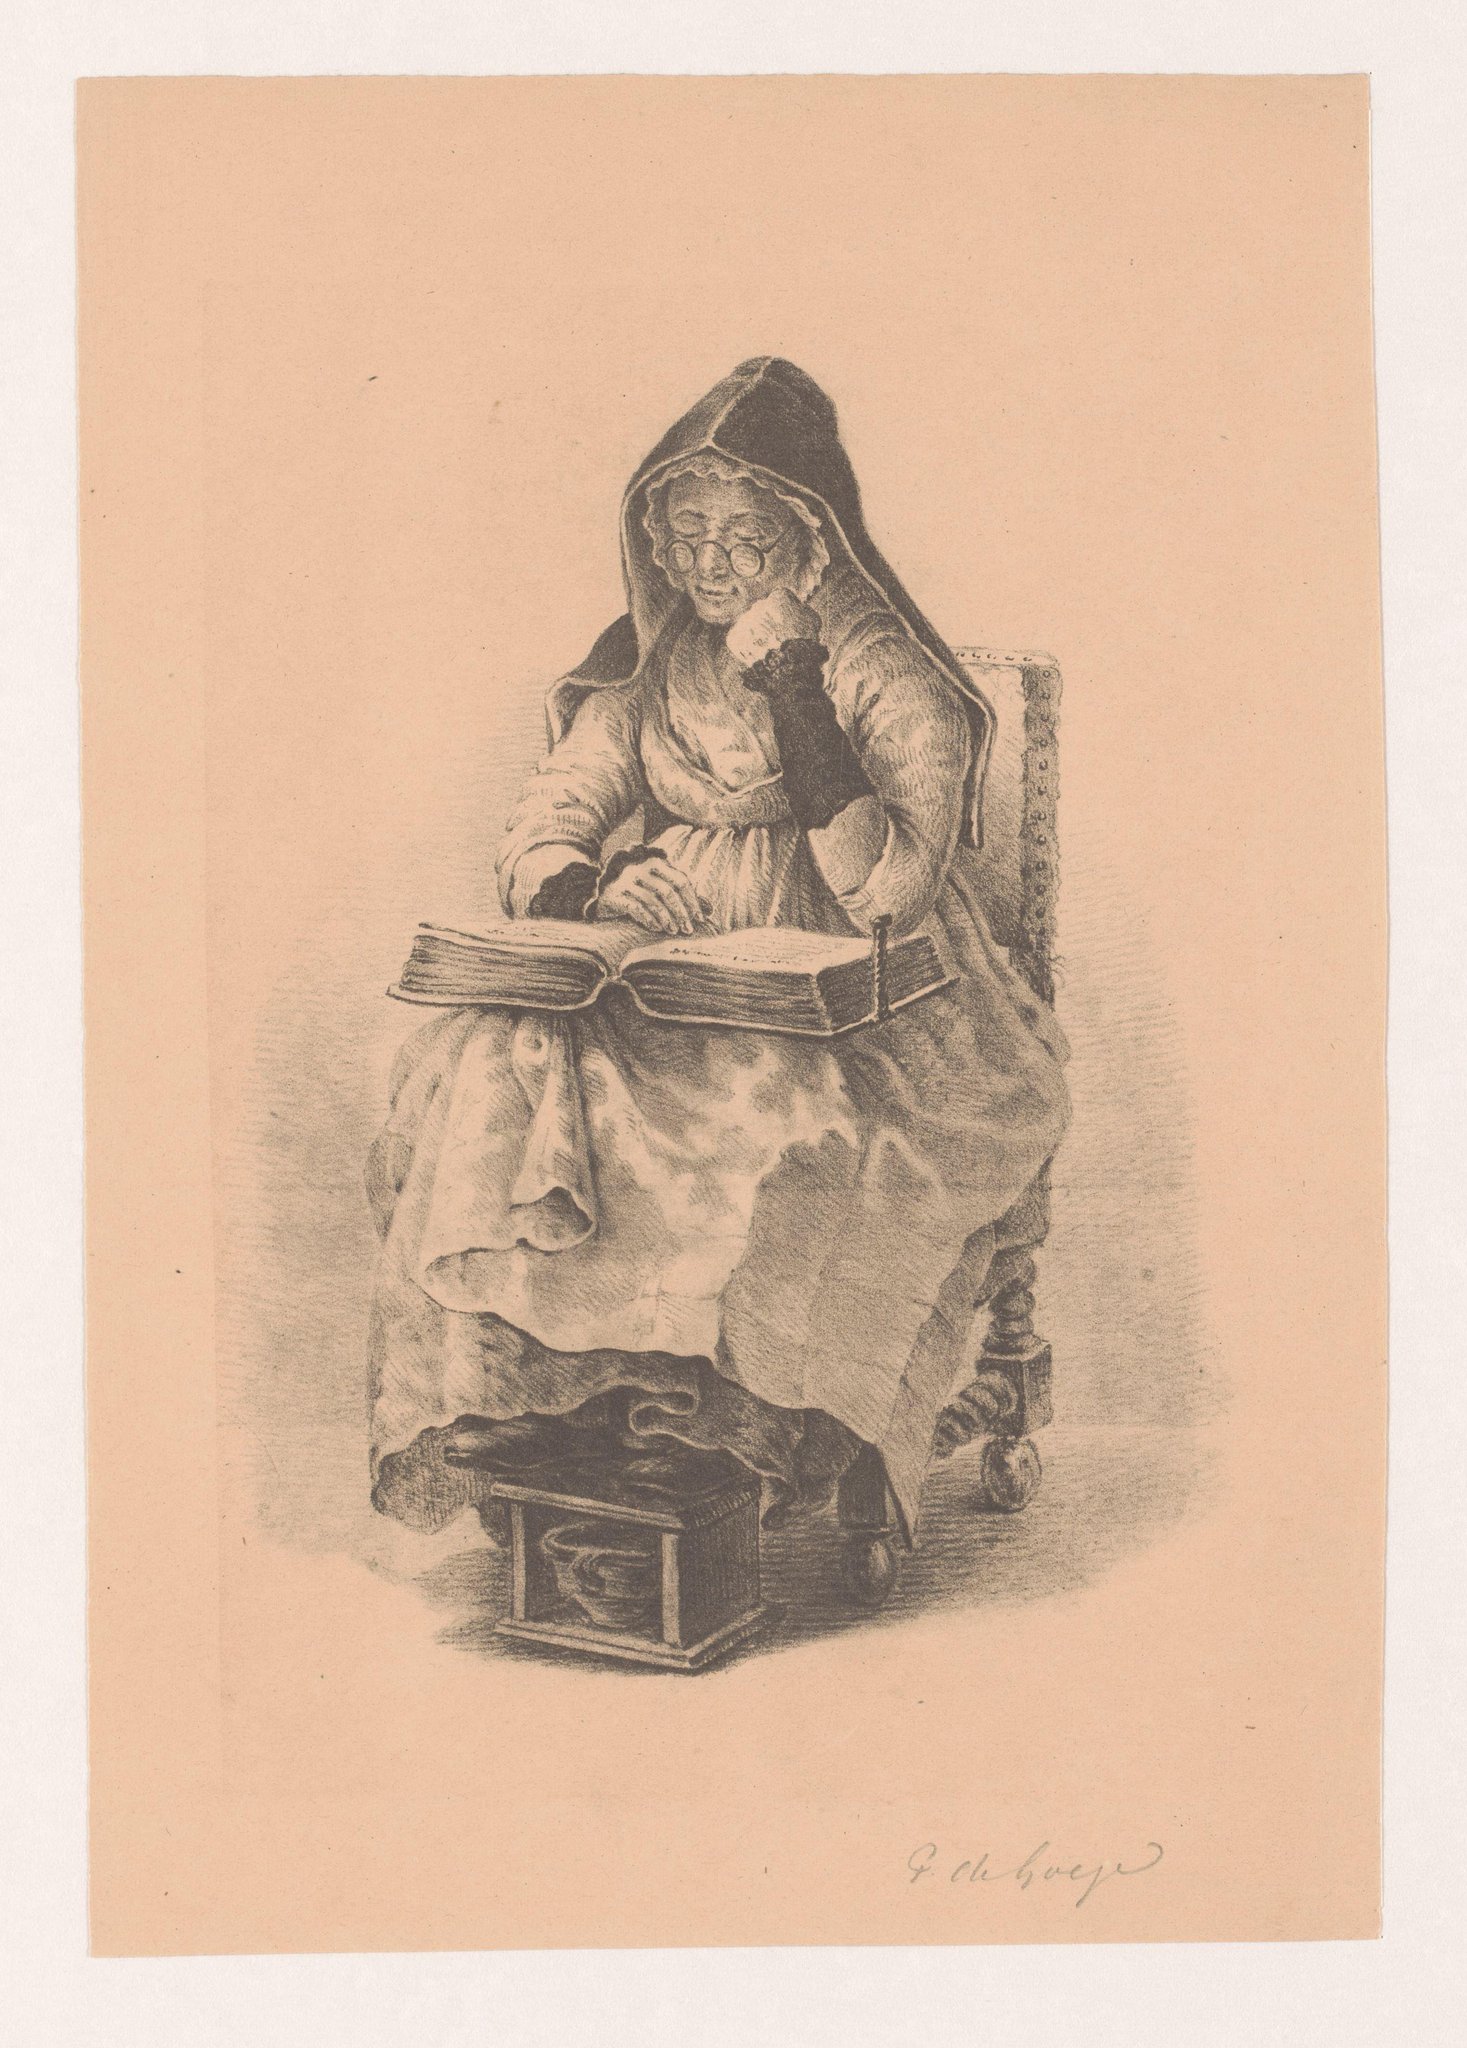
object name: print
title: Lezende vrouw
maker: pieter de goeje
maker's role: draughtsman, print maker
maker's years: 1789-1859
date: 1809-1859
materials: paper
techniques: lithograph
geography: netherlands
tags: reading, old woman (+ sitting)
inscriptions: inscription: ‘P. de Goeje’, collector's mark: Lugt 2228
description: Ze draagt een kap en een bril, ze rust met haar voeten op een stoof.